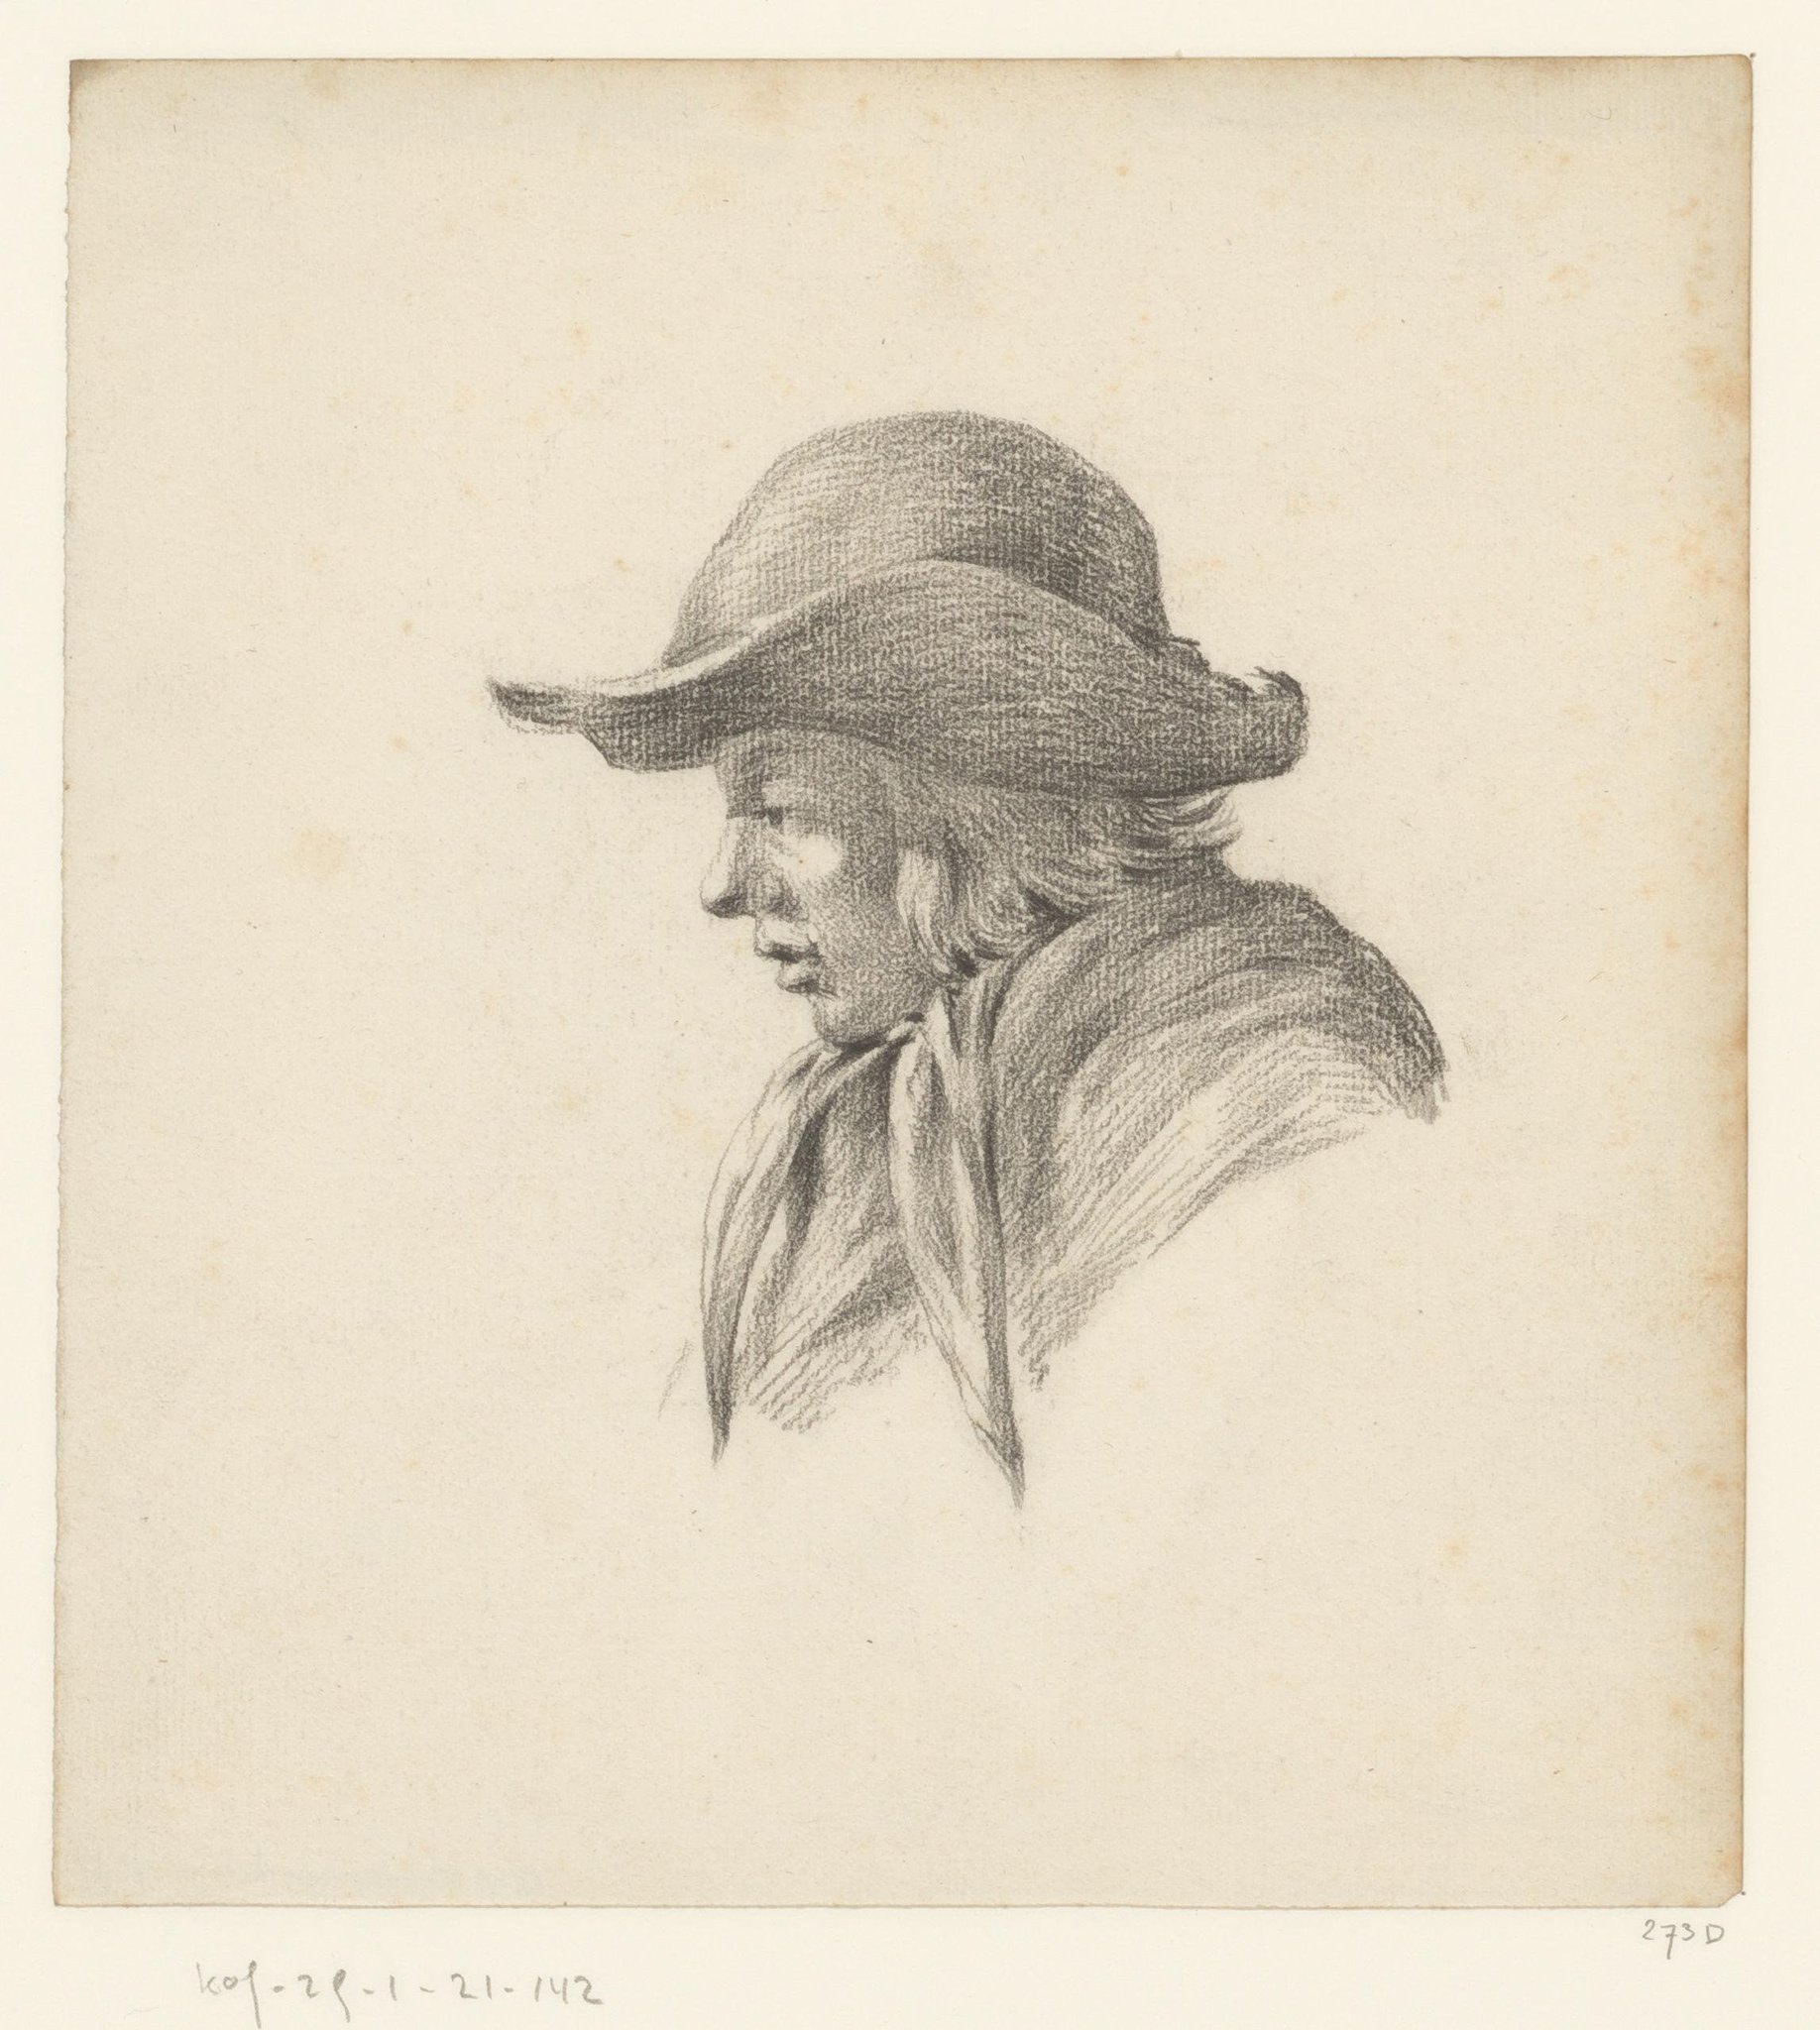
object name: drawing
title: Jongeman met grote slappe hoed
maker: Anonymous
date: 1700-1749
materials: chalk, paper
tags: youth, adolescent, head-gear: hat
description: Onderwerpsrubrieken binnen de Atlas Zeden en Gewoonten: Zeden en Gewoonten in Engeren Zin, De Kleeding, Kleederdrachten (tijdvakken), De 18de eeuw (de revolutietijd). Mannen en vrouwen.